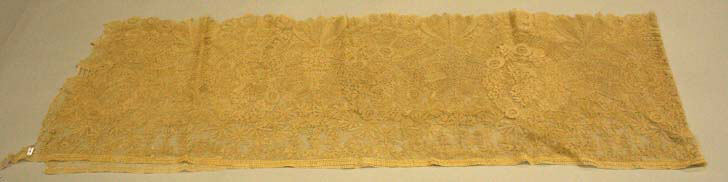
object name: textile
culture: belgian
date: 1801-1900